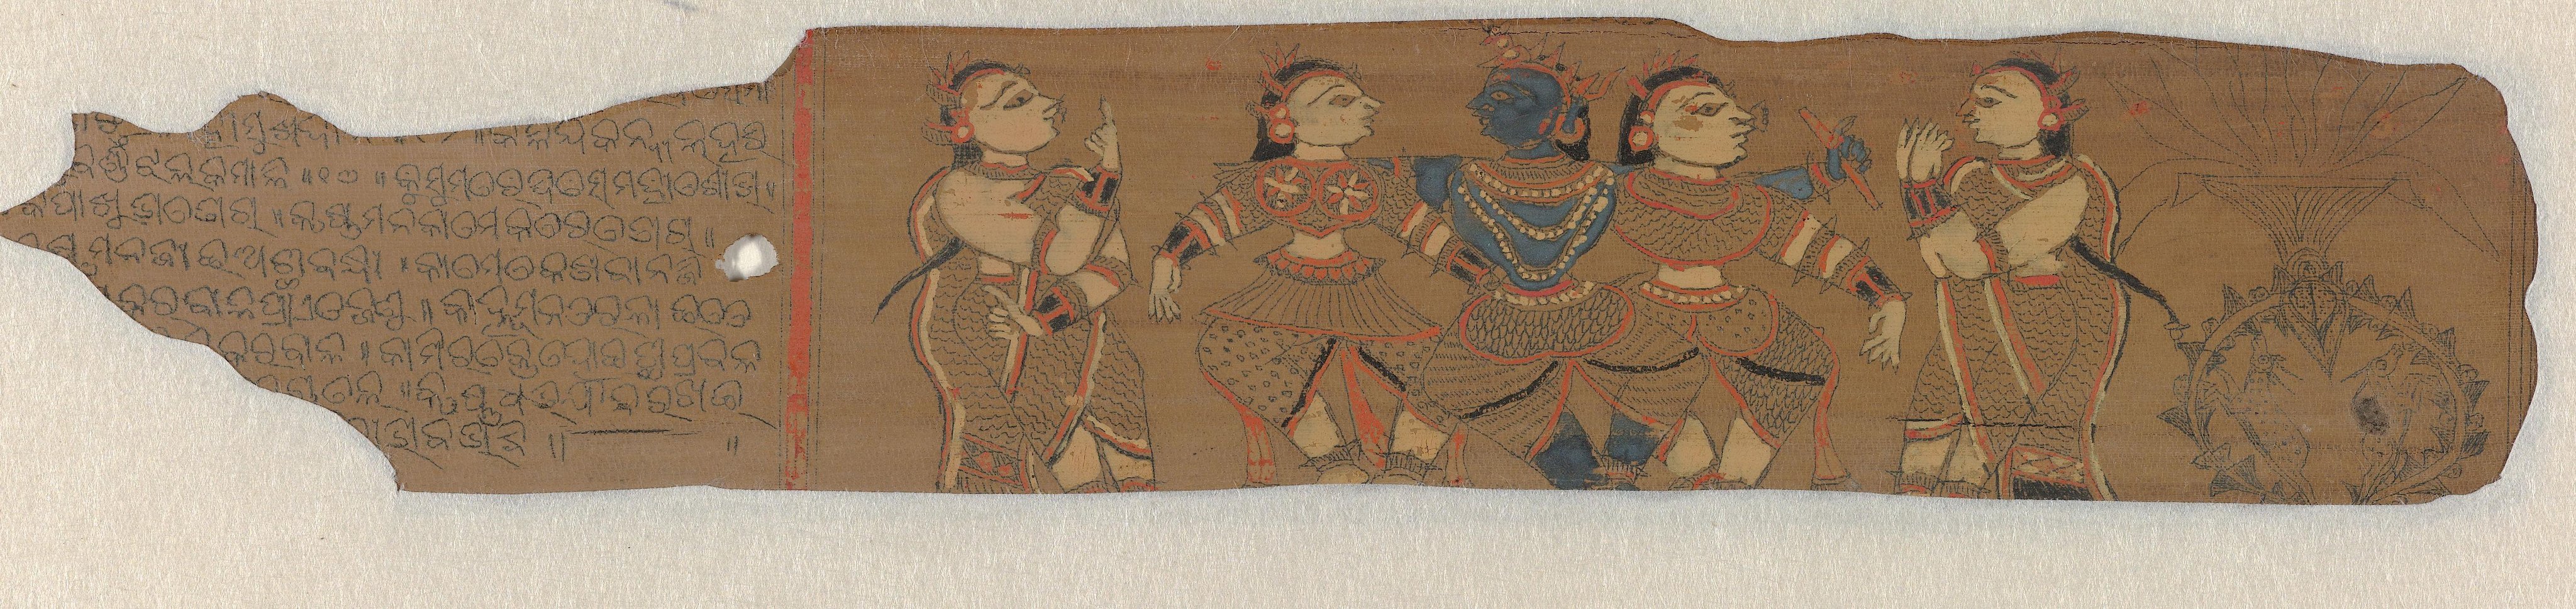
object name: indian miniature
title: Fluitspelende Krishna tussen drie dansende vrouwen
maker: Anonymous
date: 1800-1900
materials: cardboard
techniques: brush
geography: odisha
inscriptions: inscription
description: De onregelmatige linkerkant van het karton toont een stukje tekst, dan een paneeltje met ornamentele ranken van takken en bloemen en rechts een tafereel met een fluitspelende Krishna tussen drie dansende vrouwen. Onregelmatig stuk karton met links ponsgaatje en aan de linkerkant uitlopend in een smallere punt.